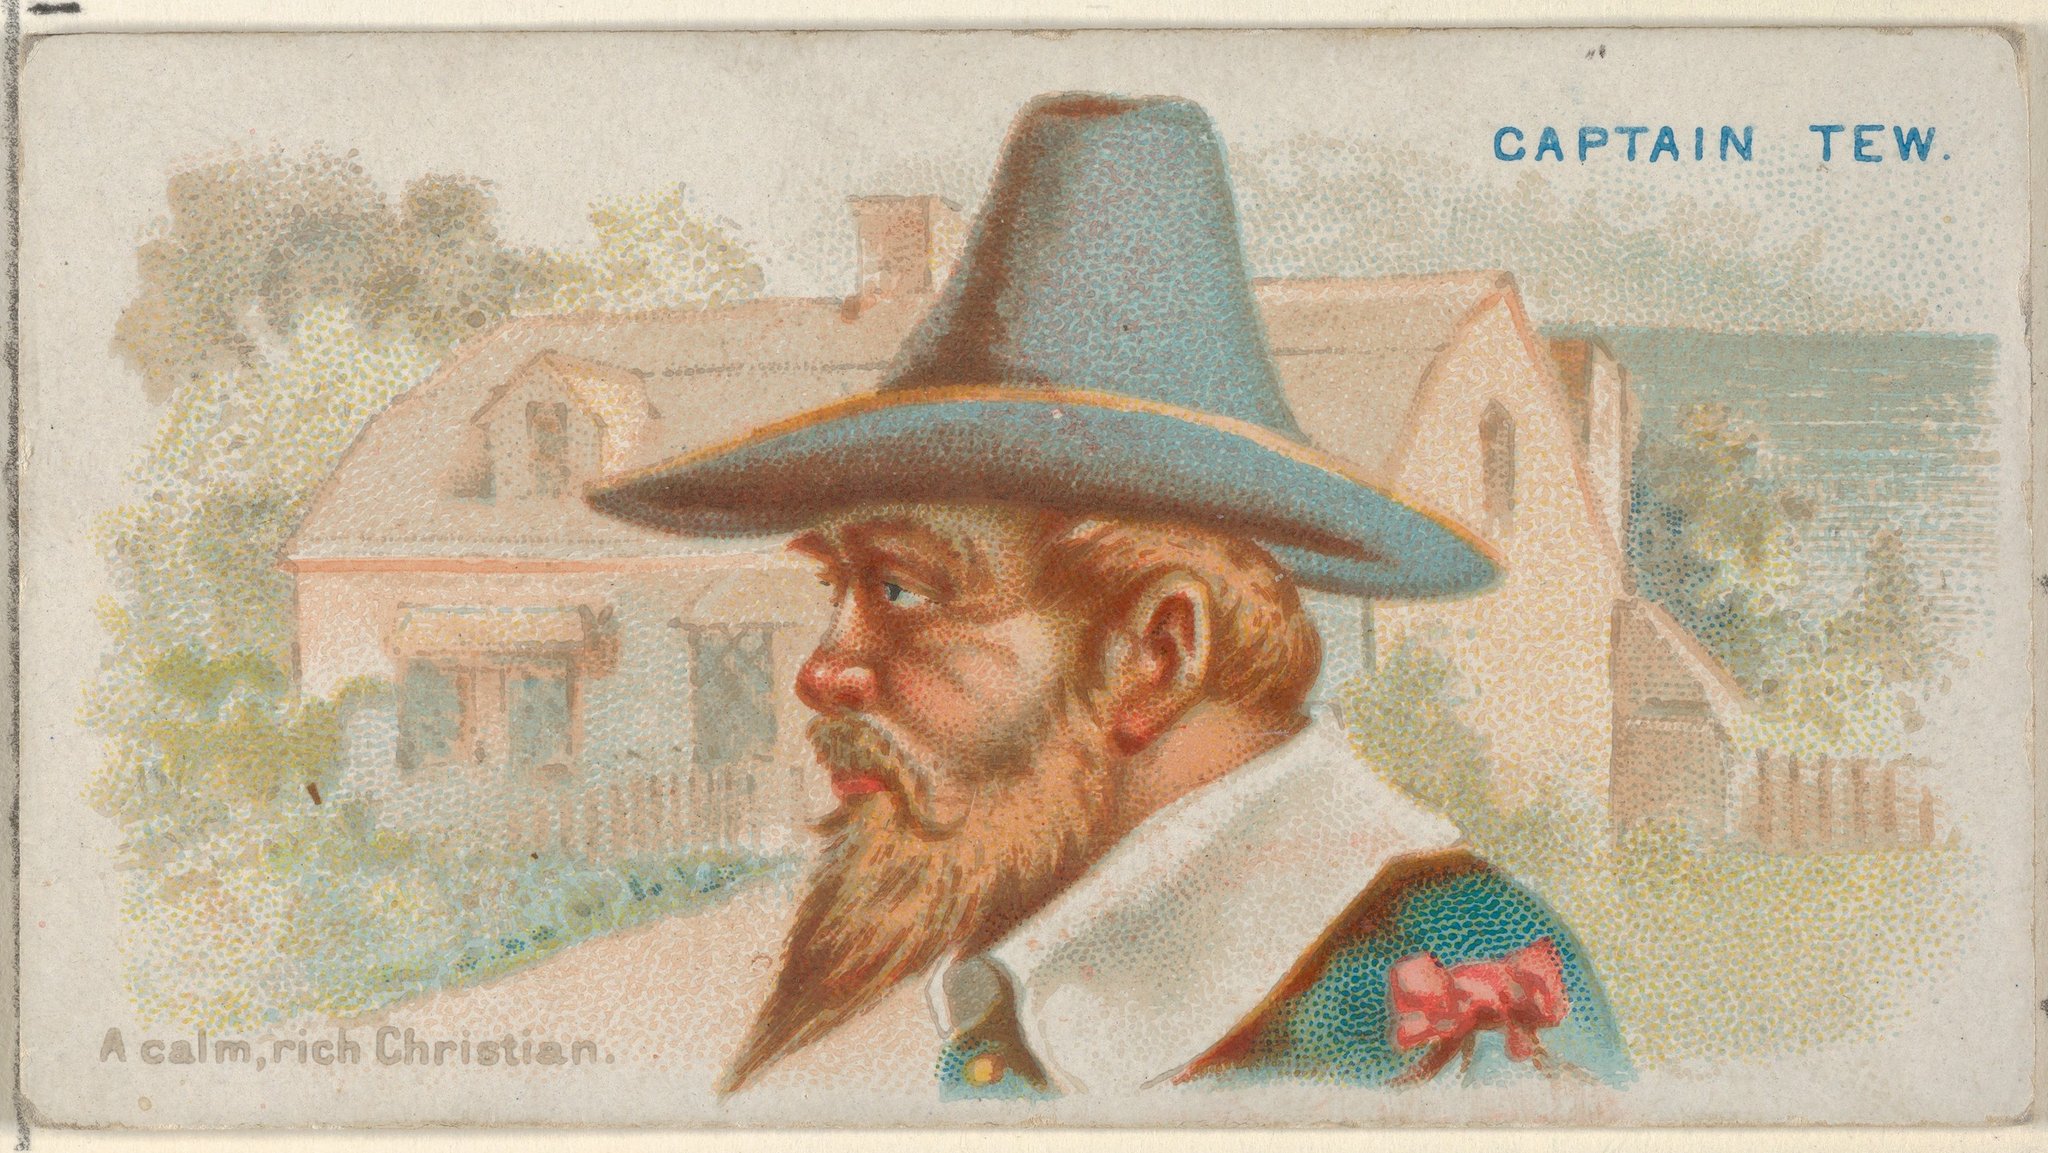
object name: print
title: Captain Tew, A Calm, Rich Christian, from the Pirates of the Spanish Main series (N19) for Allen & Ginter Cigarettes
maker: allen & ginter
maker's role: publisher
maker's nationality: american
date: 1888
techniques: color lithograph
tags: buildings,men,profiles